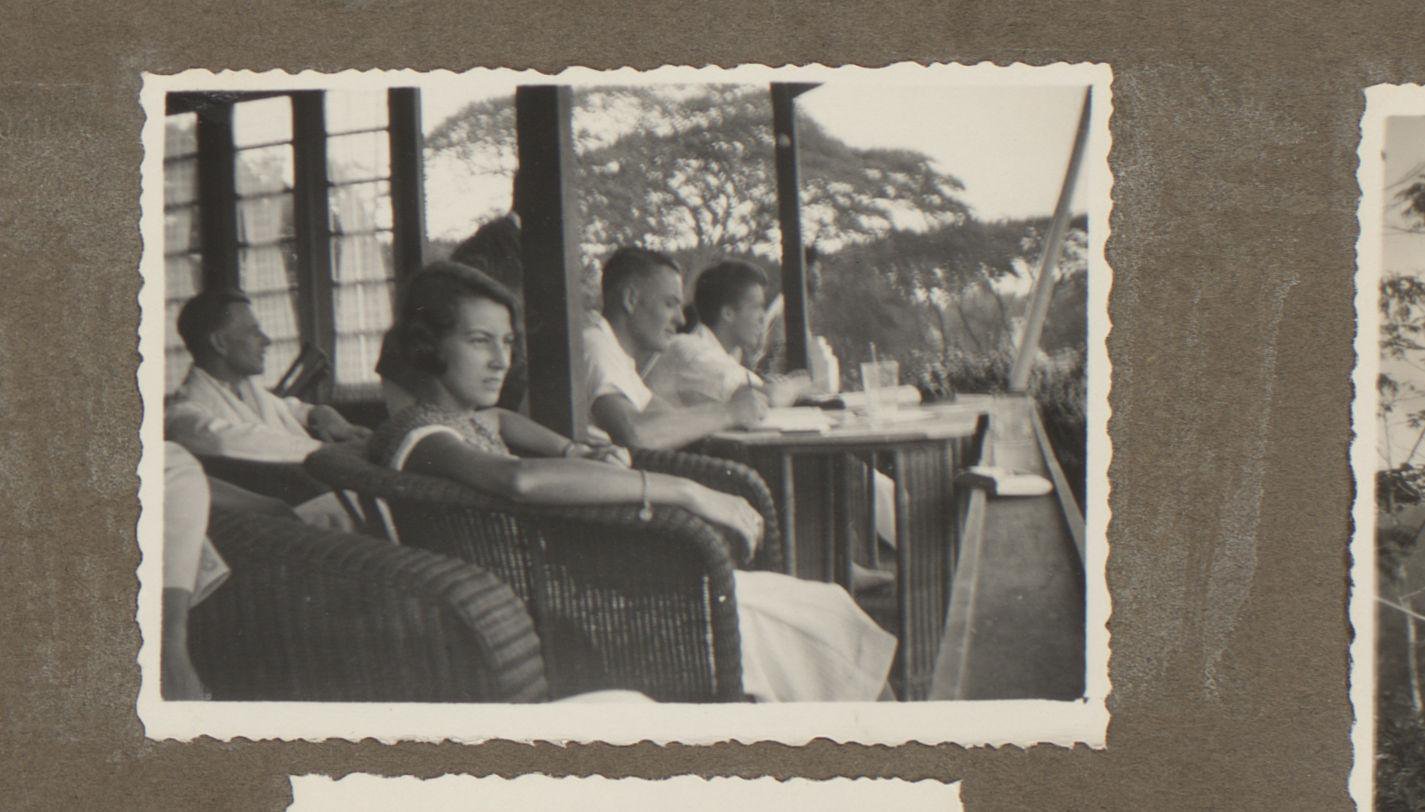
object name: album leaf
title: Ada Krüseman op een veranda, Tjibeber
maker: Anonymous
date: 1932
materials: paper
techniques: gelatin silver print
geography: tjibeber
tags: historical persons - bb - woman, loggia, verandah, porch